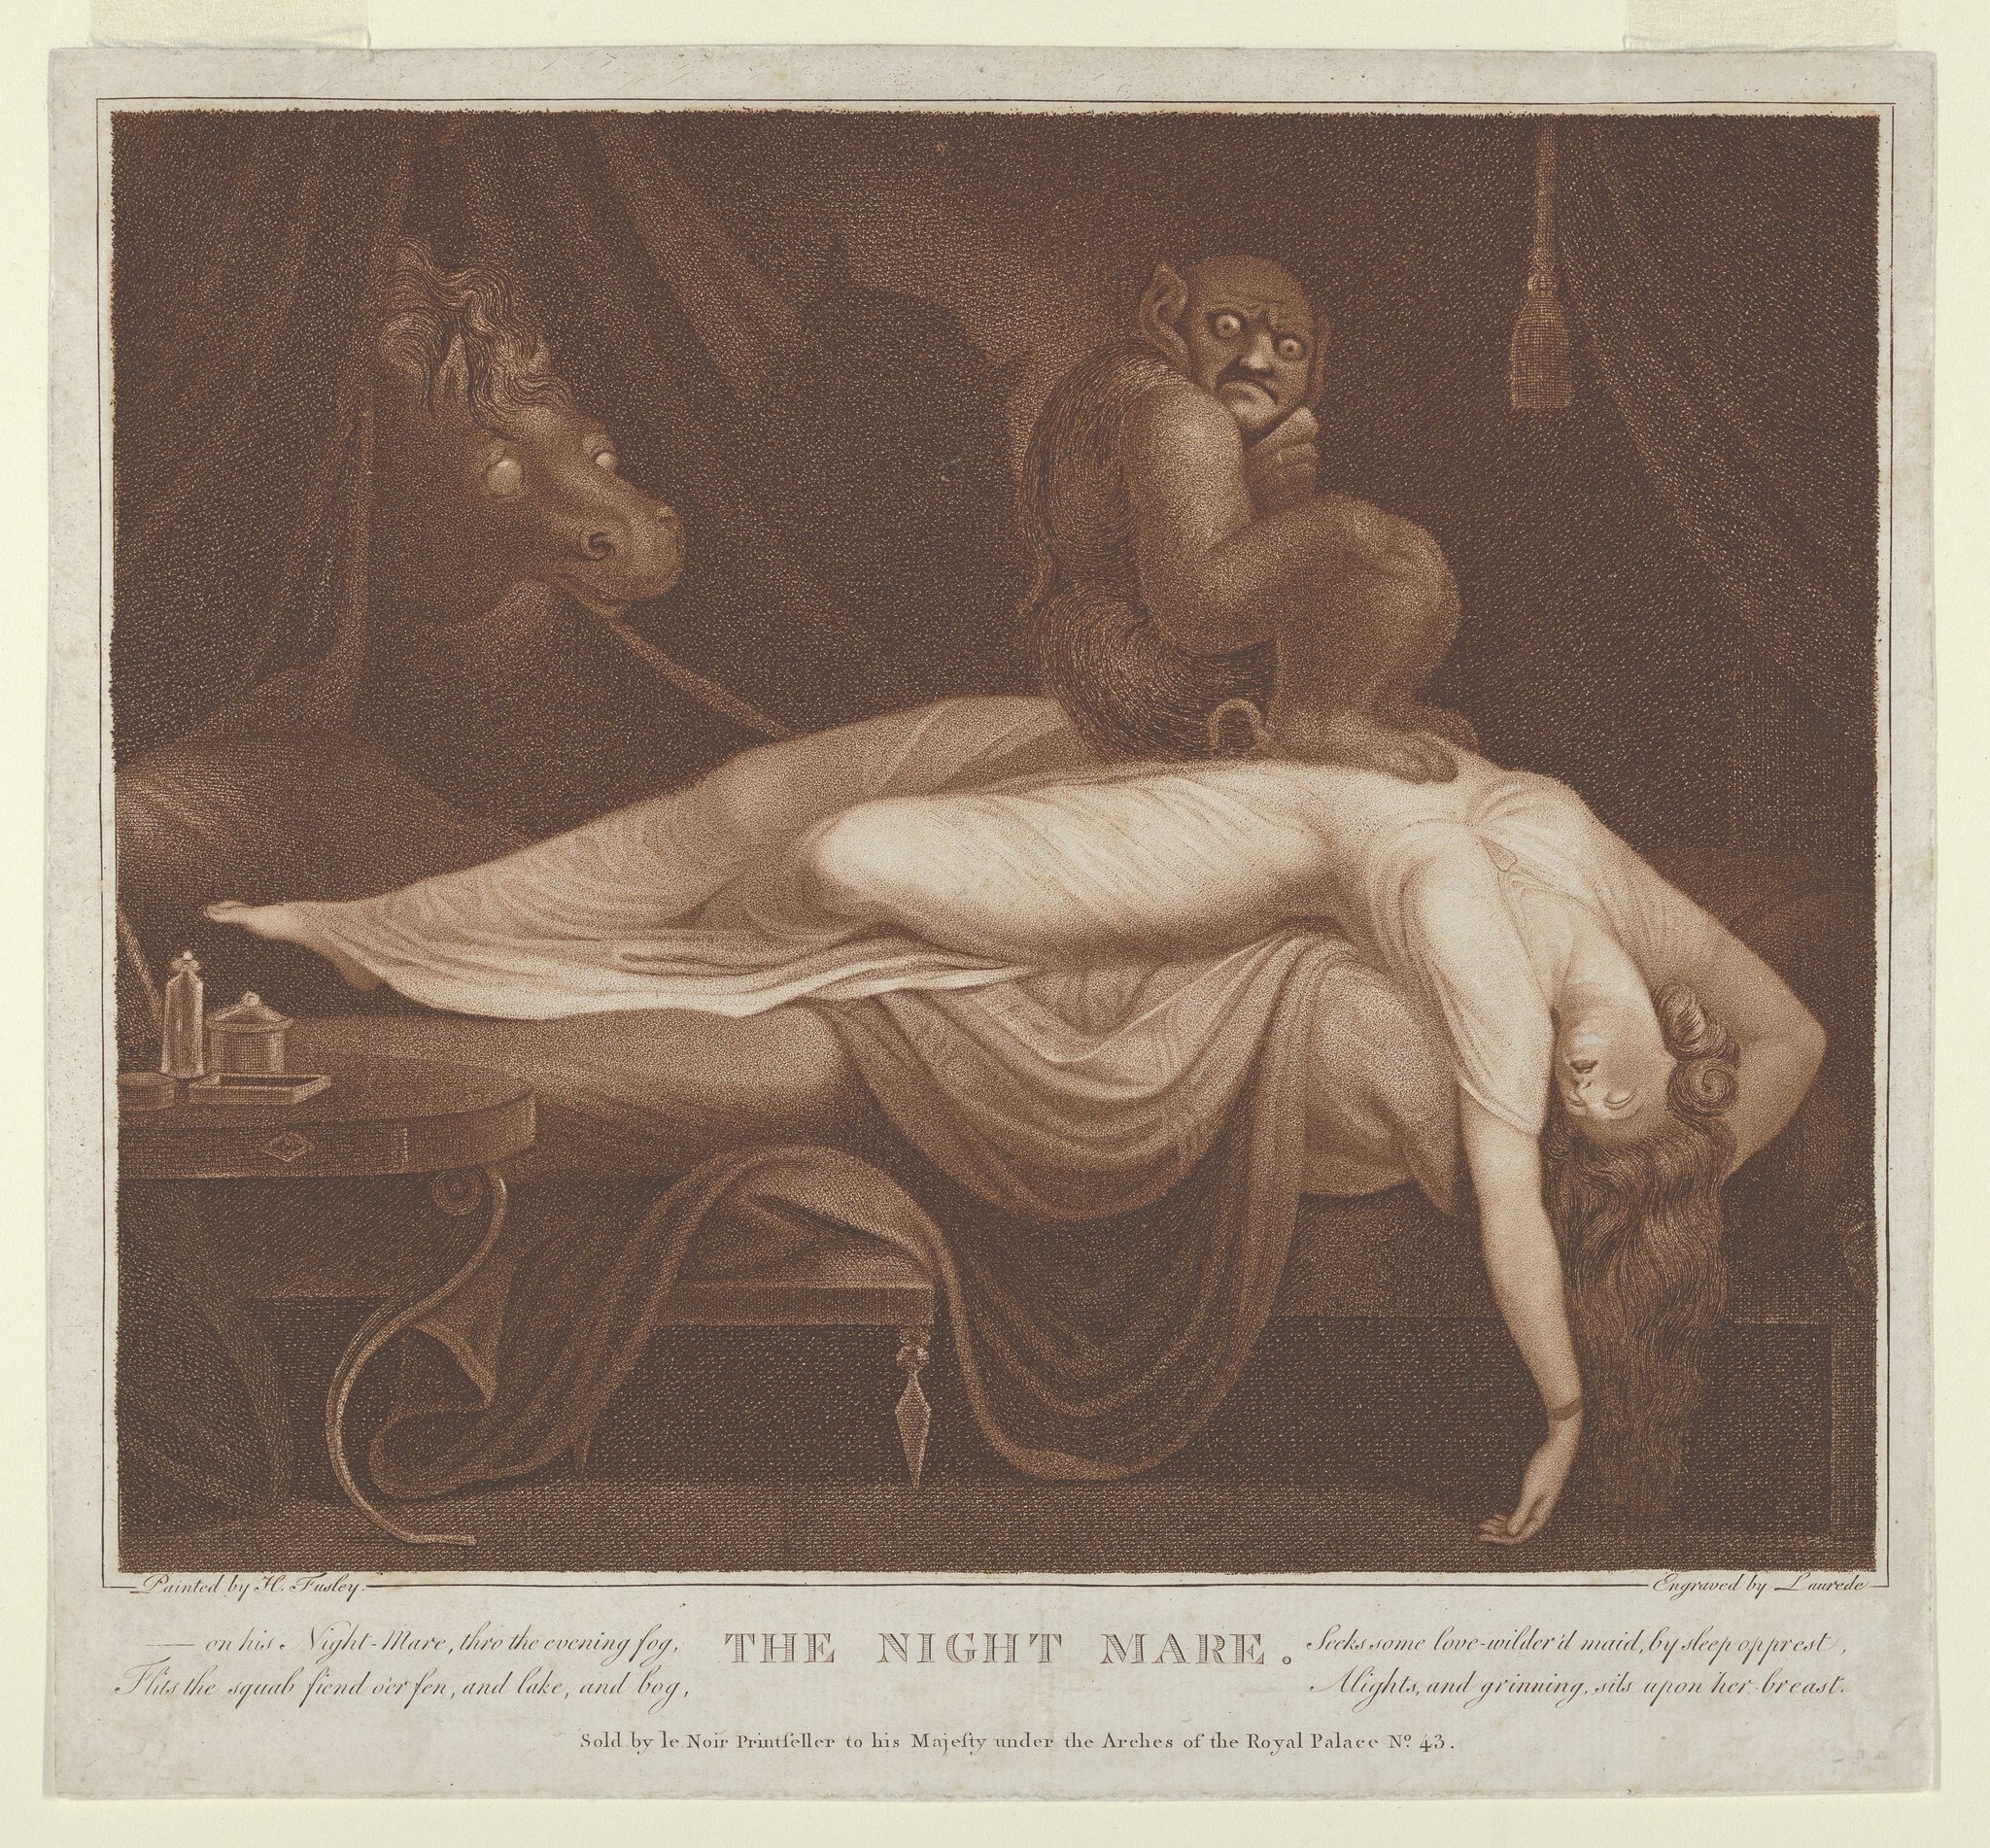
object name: print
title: The Night Mare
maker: laurede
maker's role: engraver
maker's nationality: french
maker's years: 1780-1850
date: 1782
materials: ink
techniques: printing, engraving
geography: paris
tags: fear,sleeping,women,mythical creatures,horses